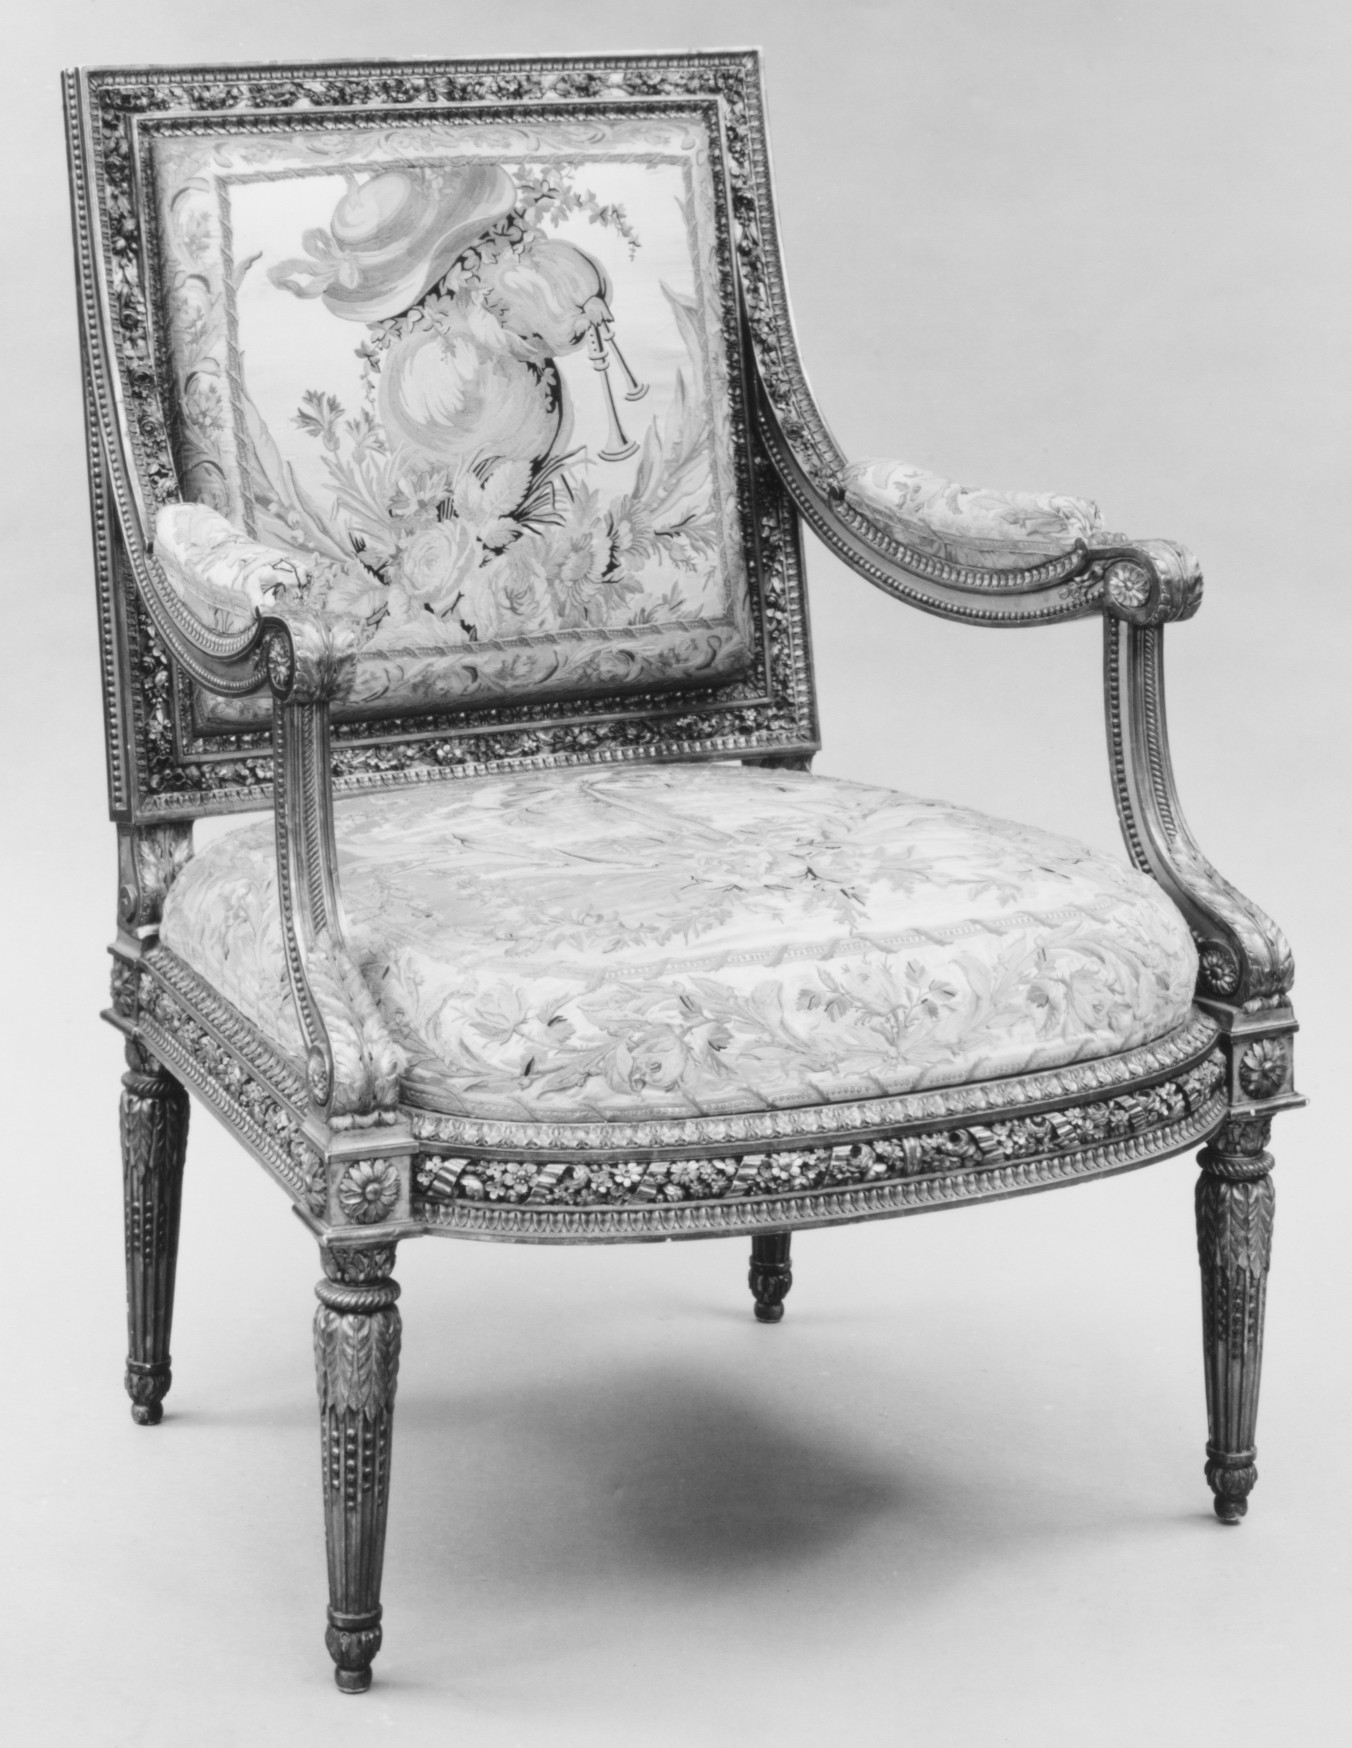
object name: armchair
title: Armchair (part of a set)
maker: carlhian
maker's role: maker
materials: wood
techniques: carving, gilding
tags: flowers